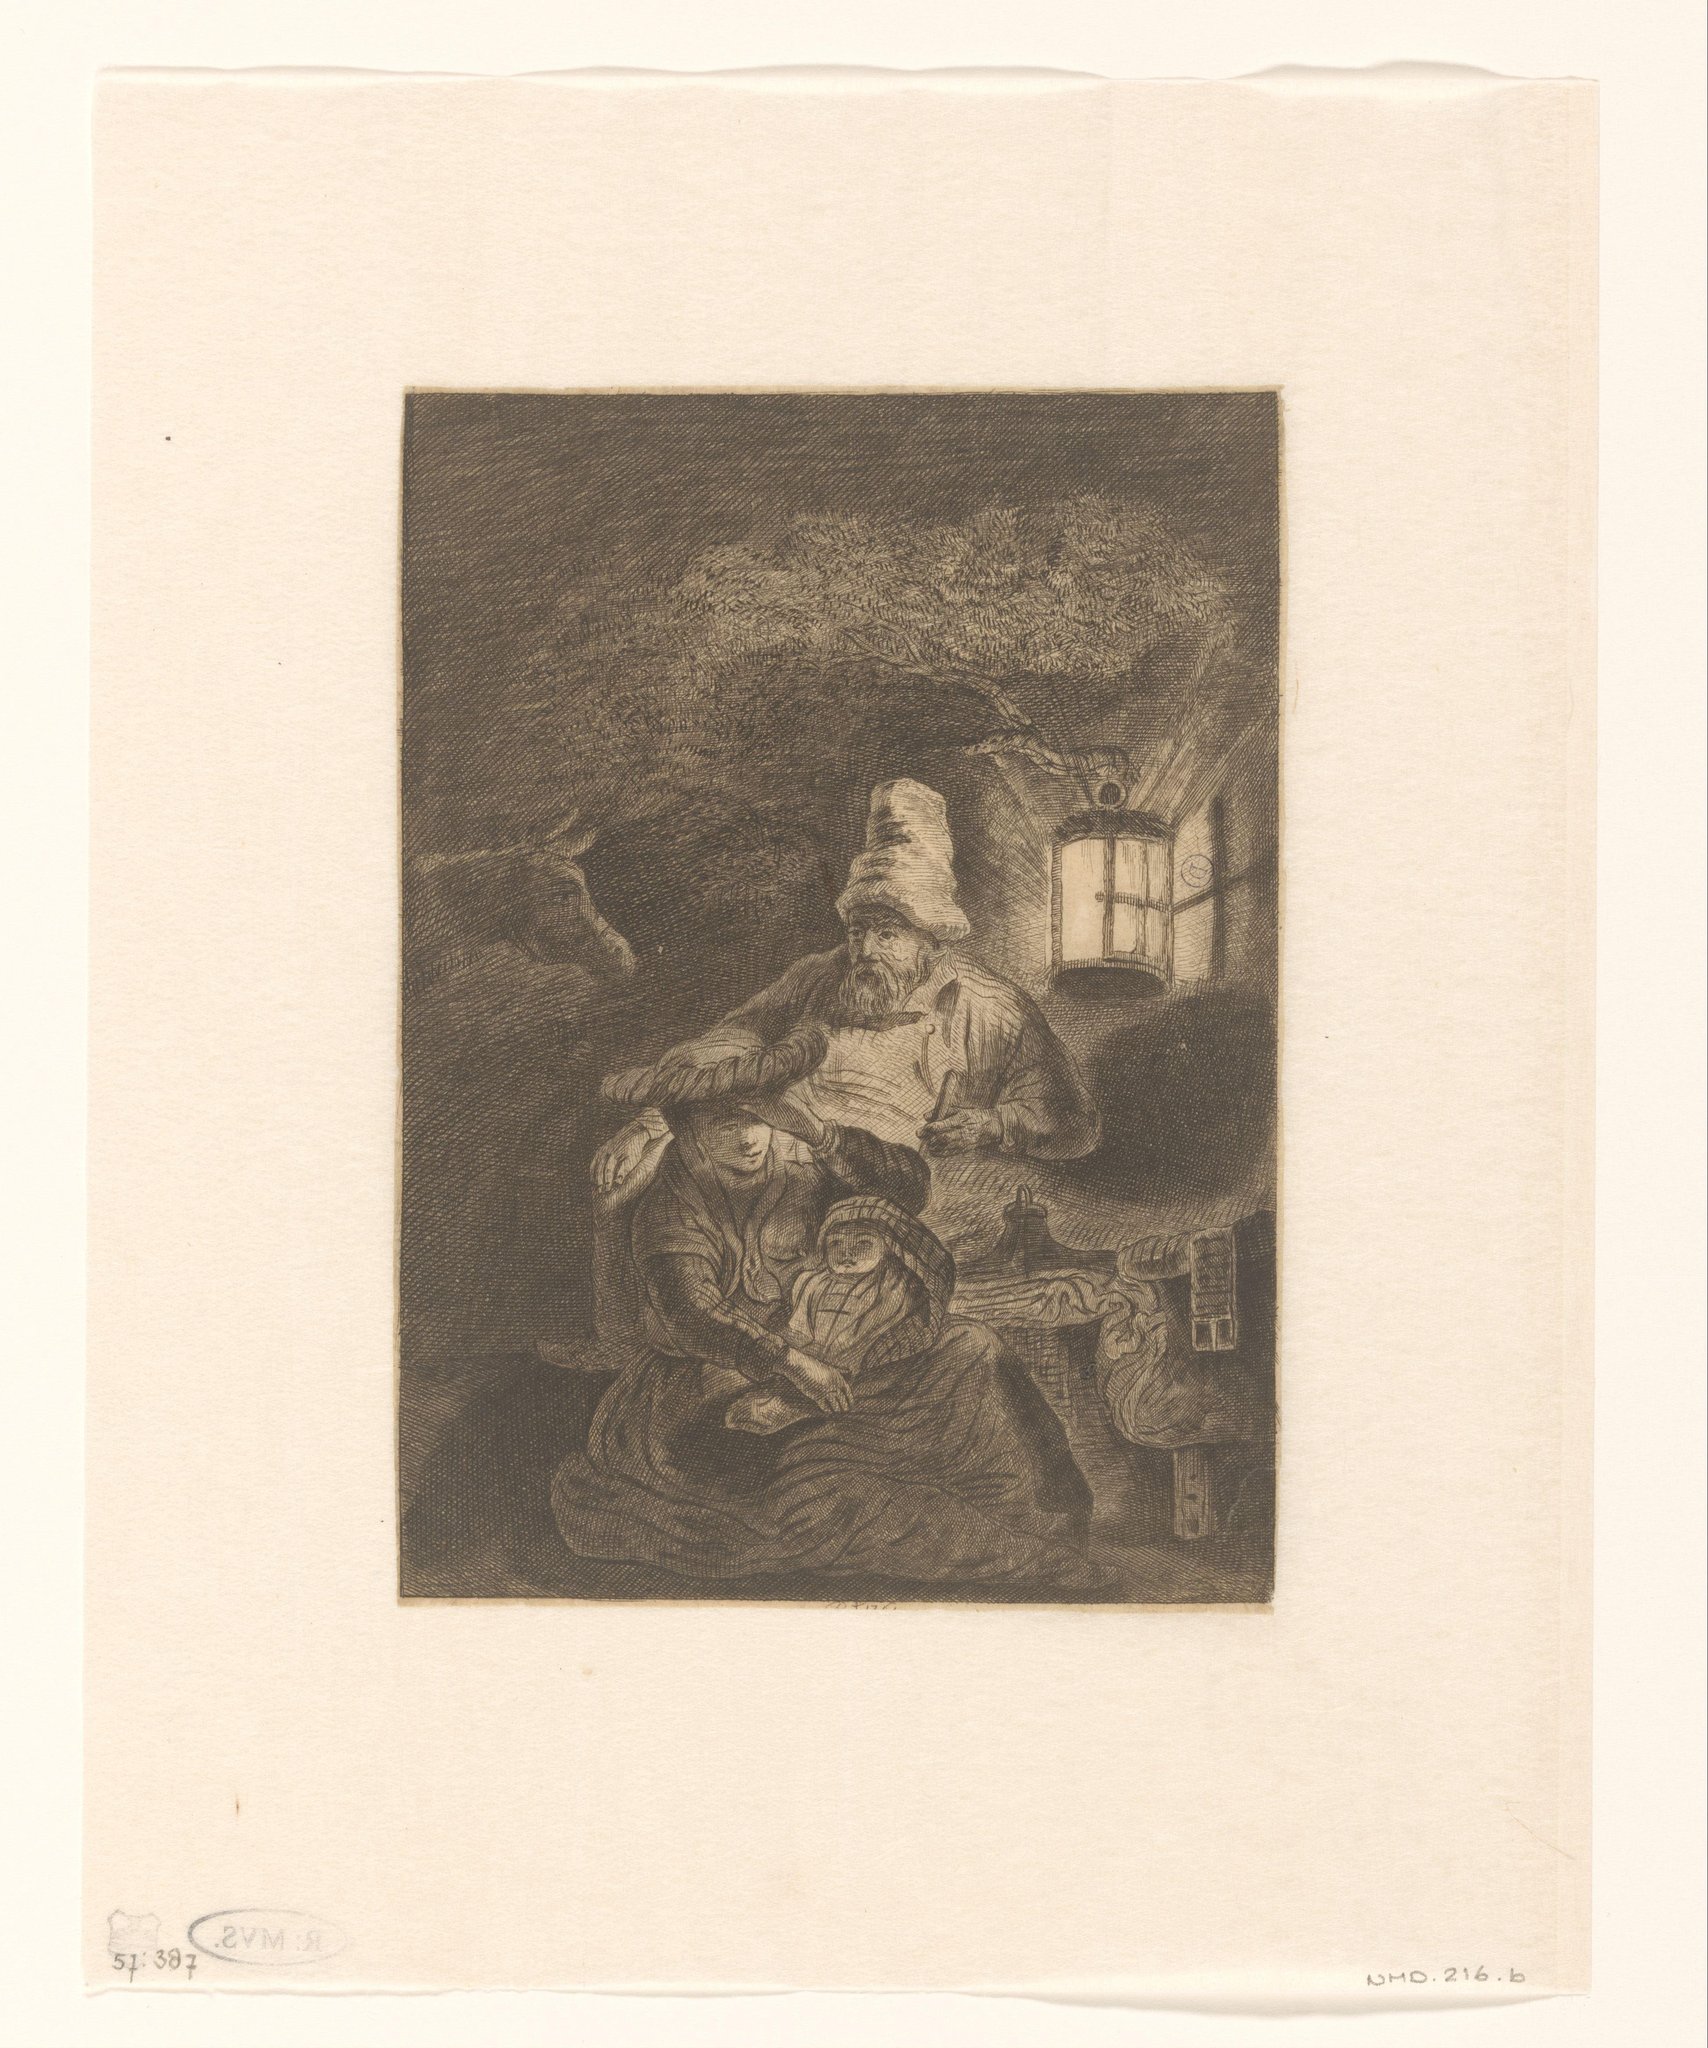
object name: print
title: Rest on the flight into Egypt: a night piece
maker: Anonymous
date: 1644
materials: paper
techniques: etching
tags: the flight into egypt: mary, joseph, the child (and sometimes others) on their way; mary usually riding on an ass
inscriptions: collector's mark: Lugt 2228, collector's mark: Lugt 2760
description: Spiegelbeeldige kopie naar de gelijknamige prent van Rembrandt.